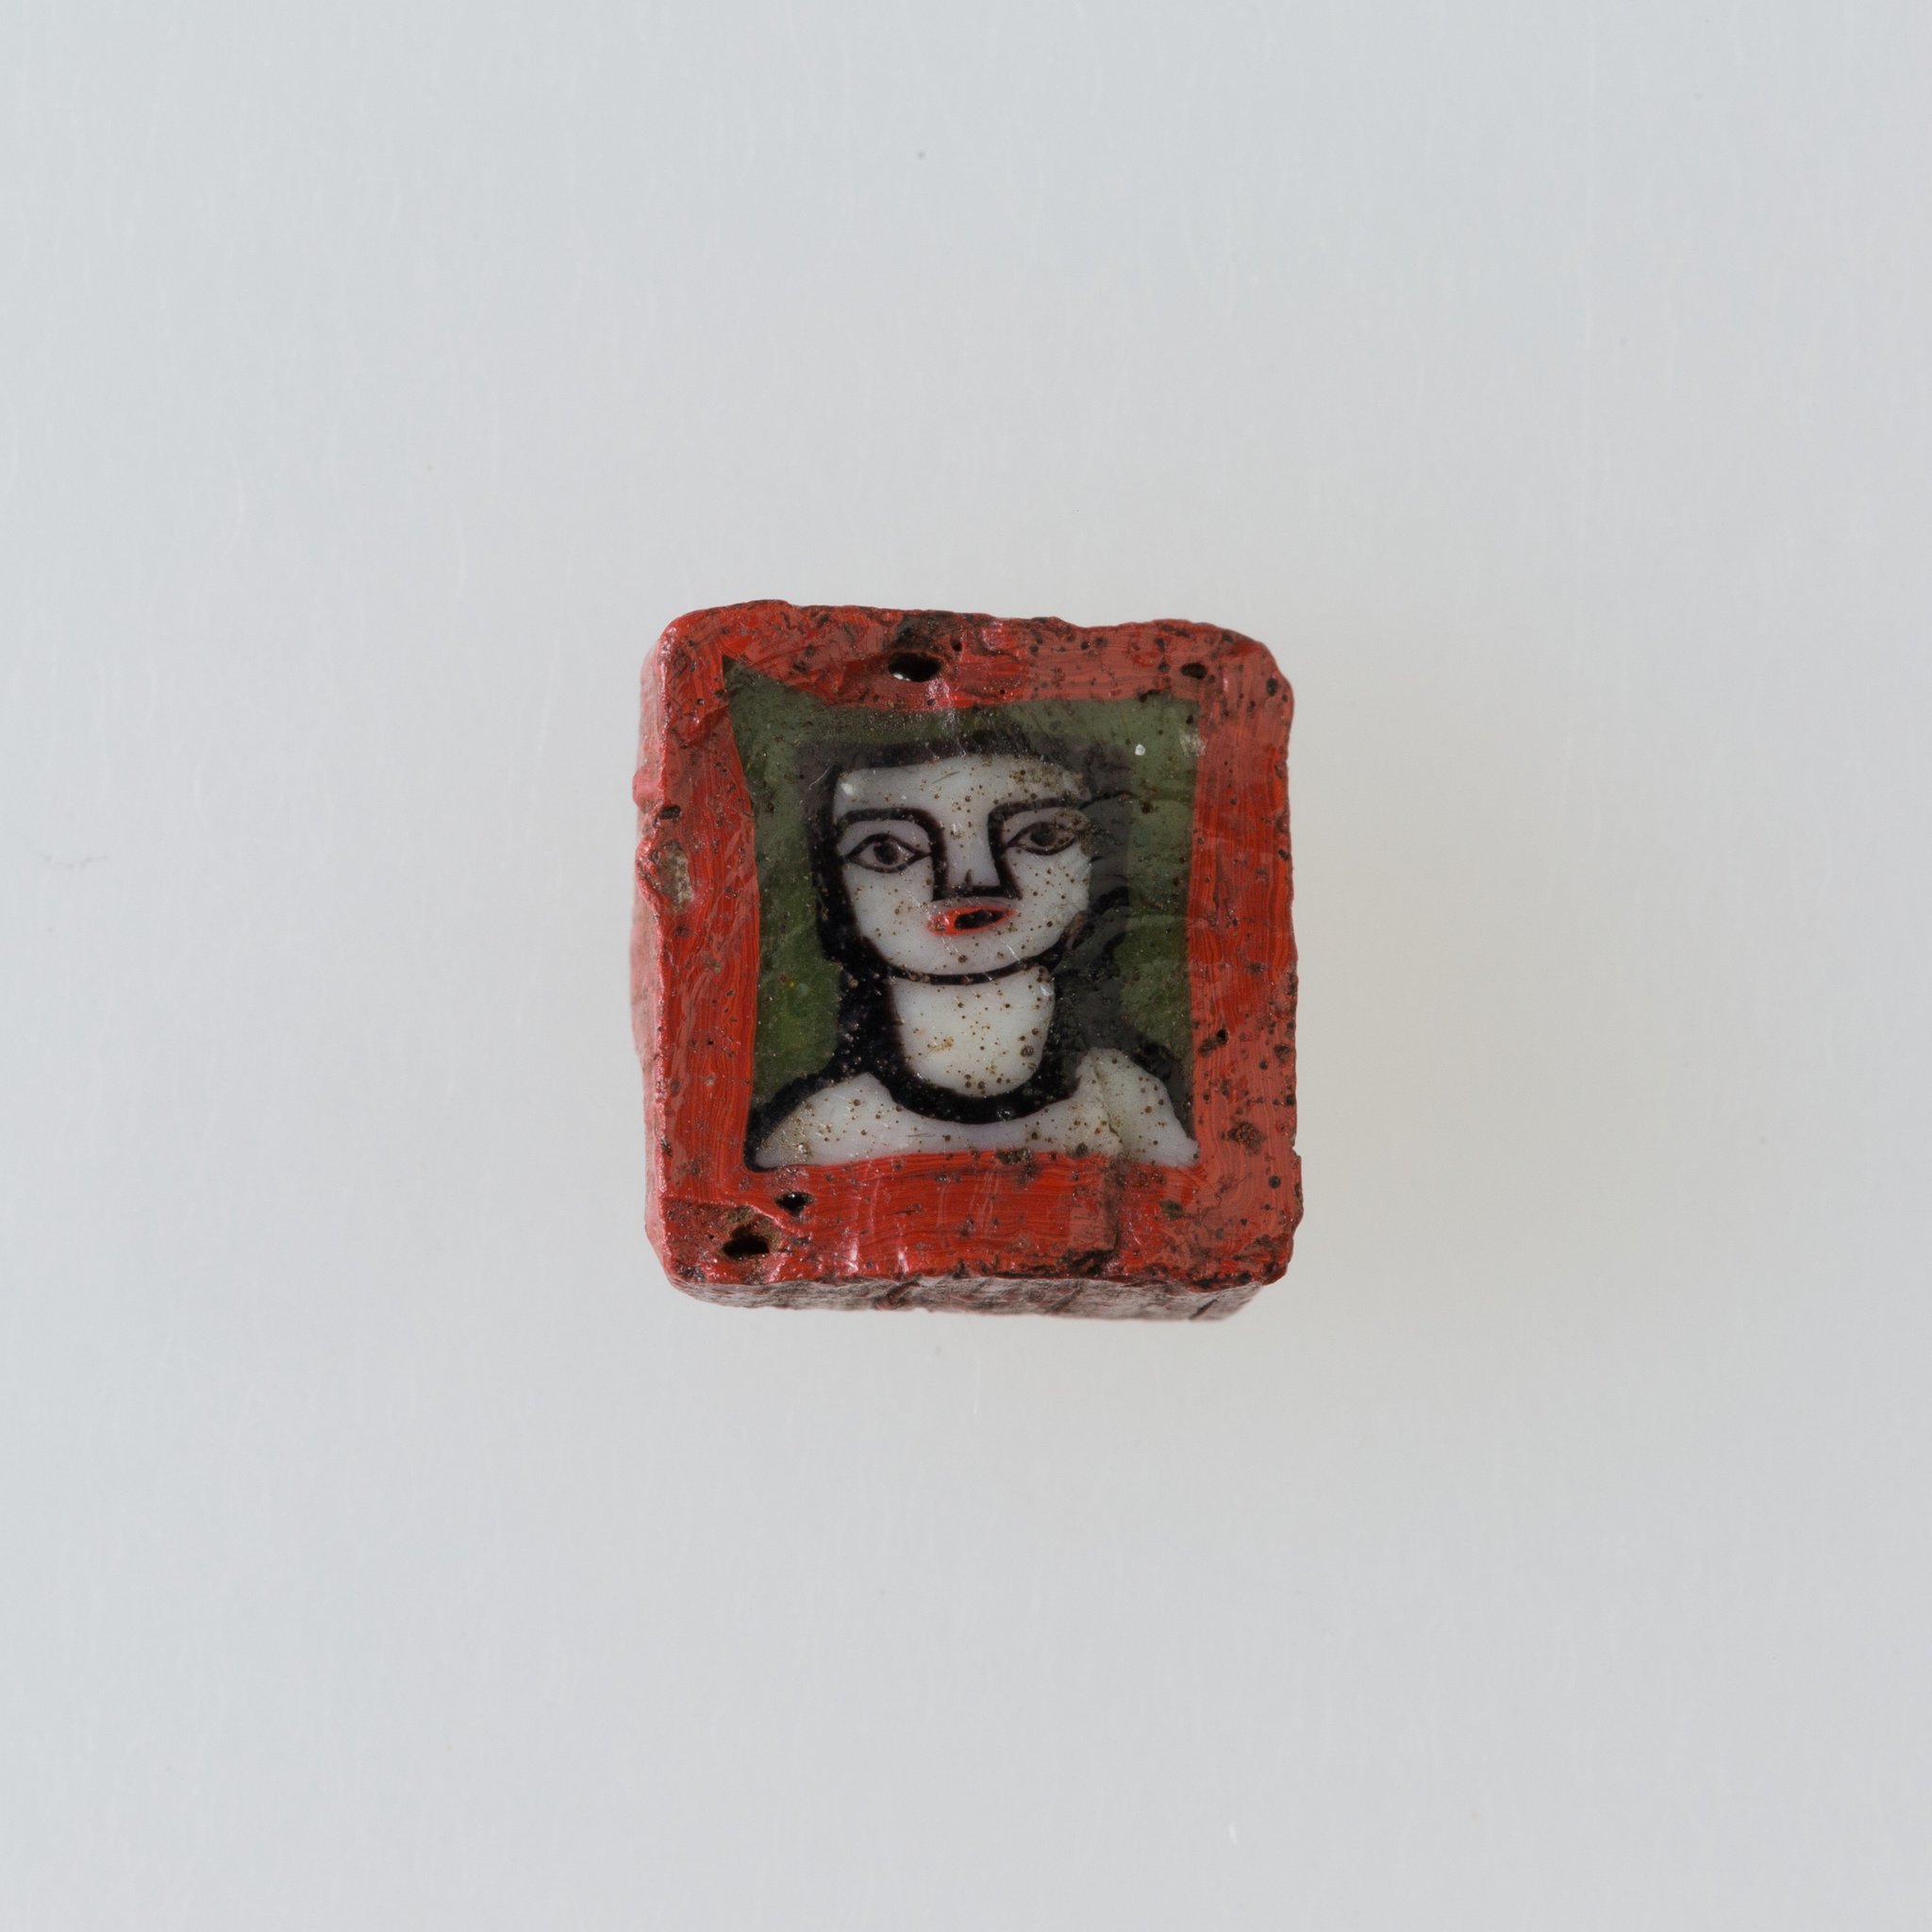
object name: inlay, face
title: Inlay / bead blank with face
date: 100 BCE-100 CE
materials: glass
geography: egypt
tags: faces